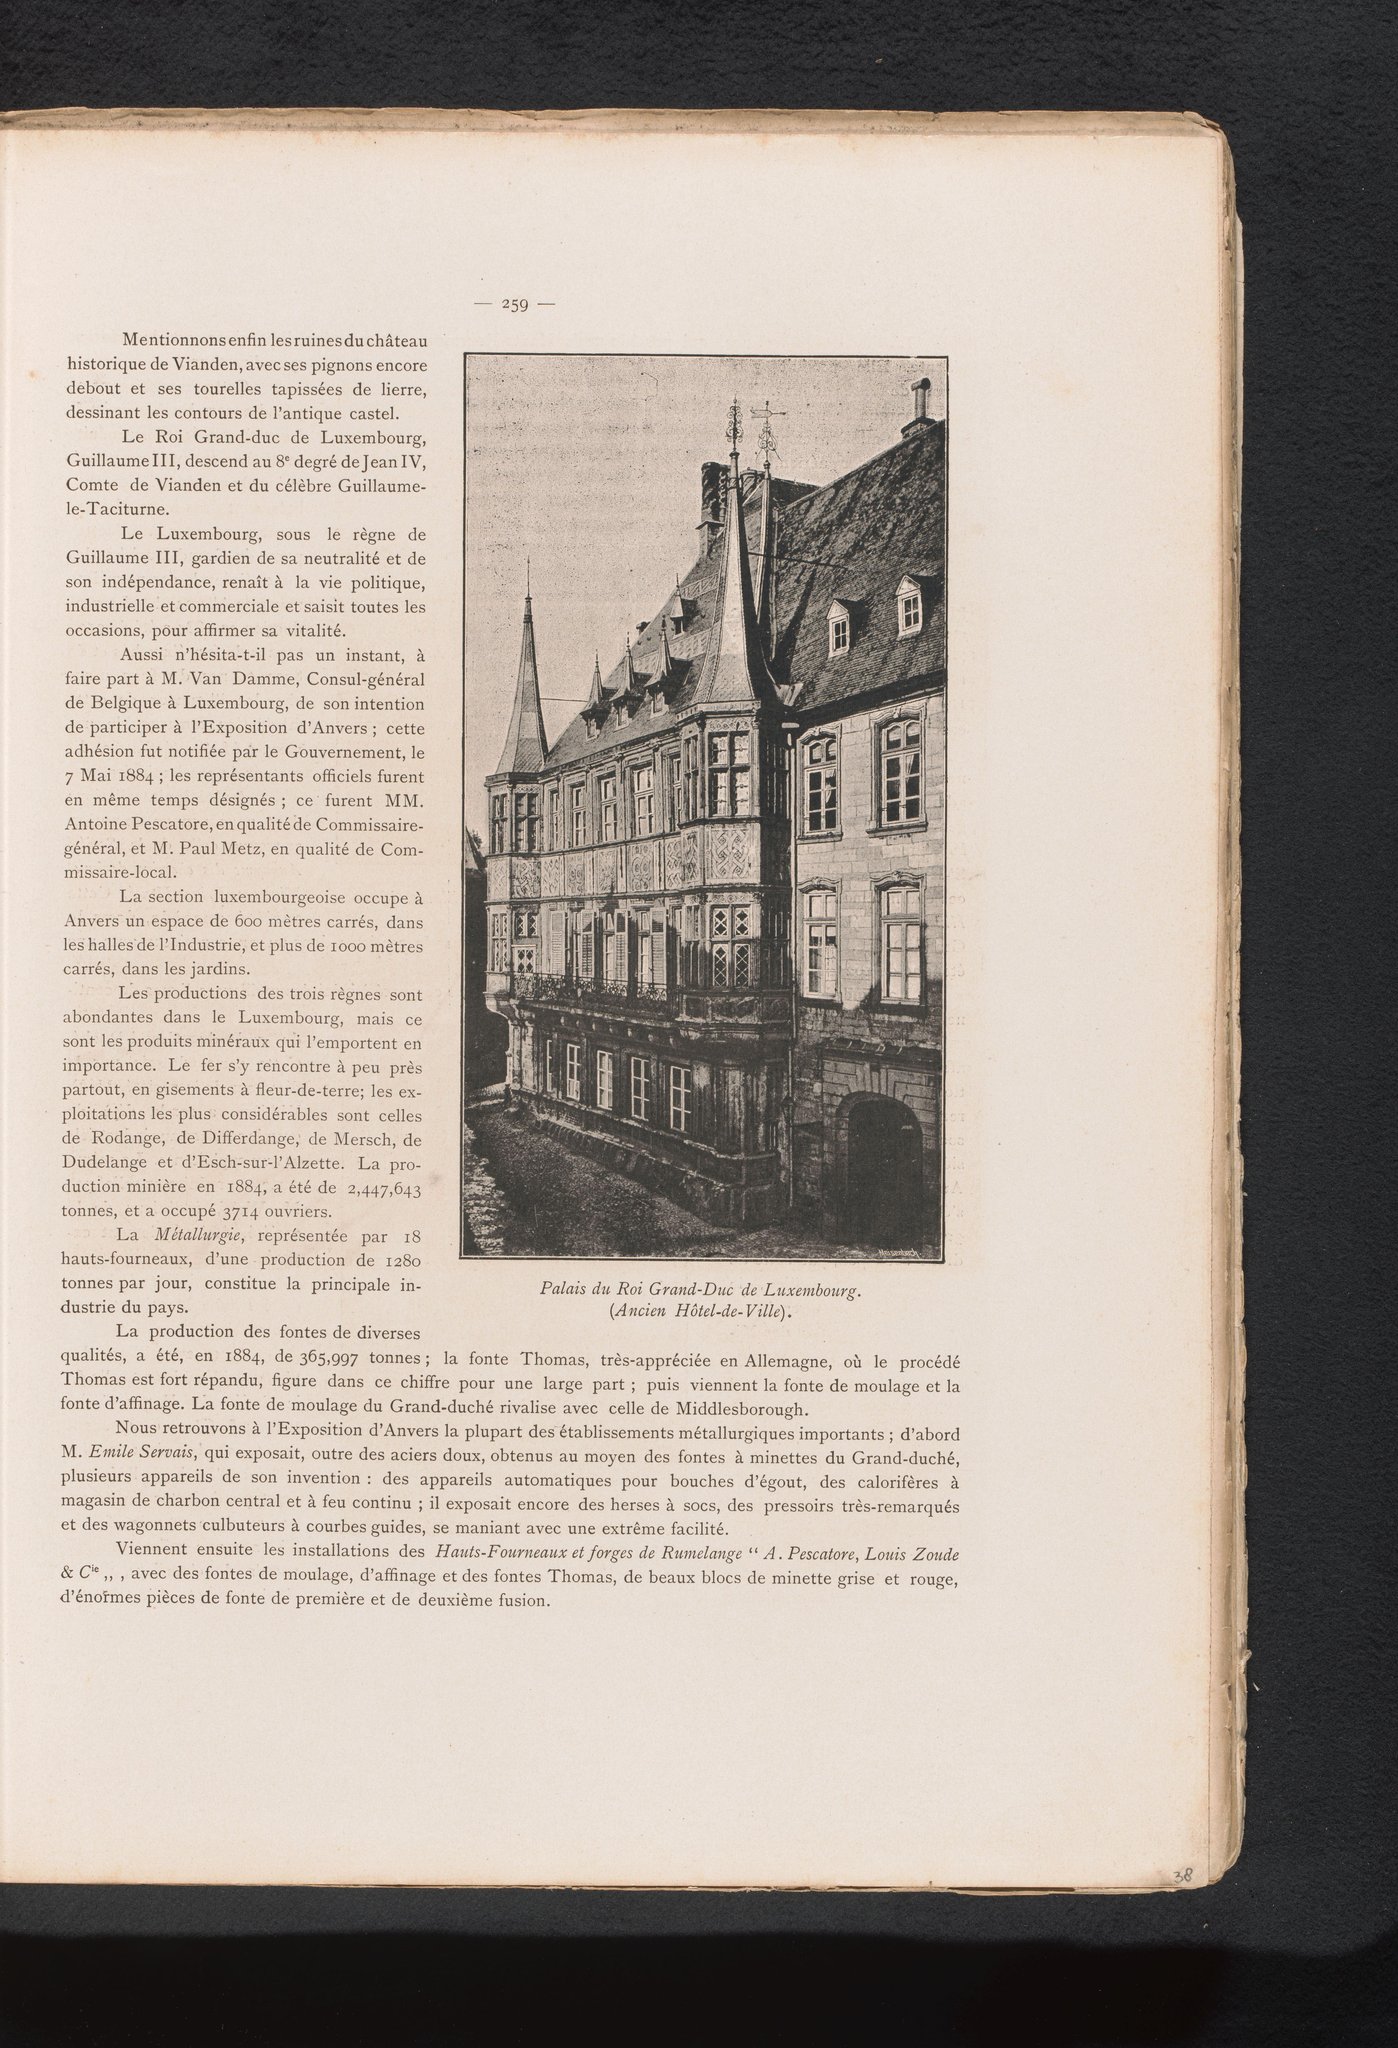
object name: photomechanical print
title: Palais du Roi Grand-Duc de Luxembourg (Ancien Hôtel-de-Ville)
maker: Anonymous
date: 1880-1885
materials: paper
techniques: autotype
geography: luxembourg city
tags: palace